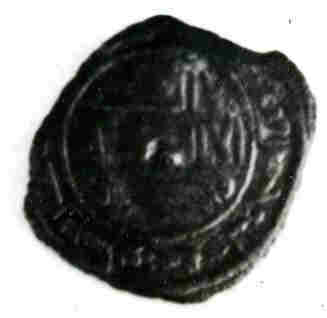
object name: coin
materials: copper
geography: nishapur